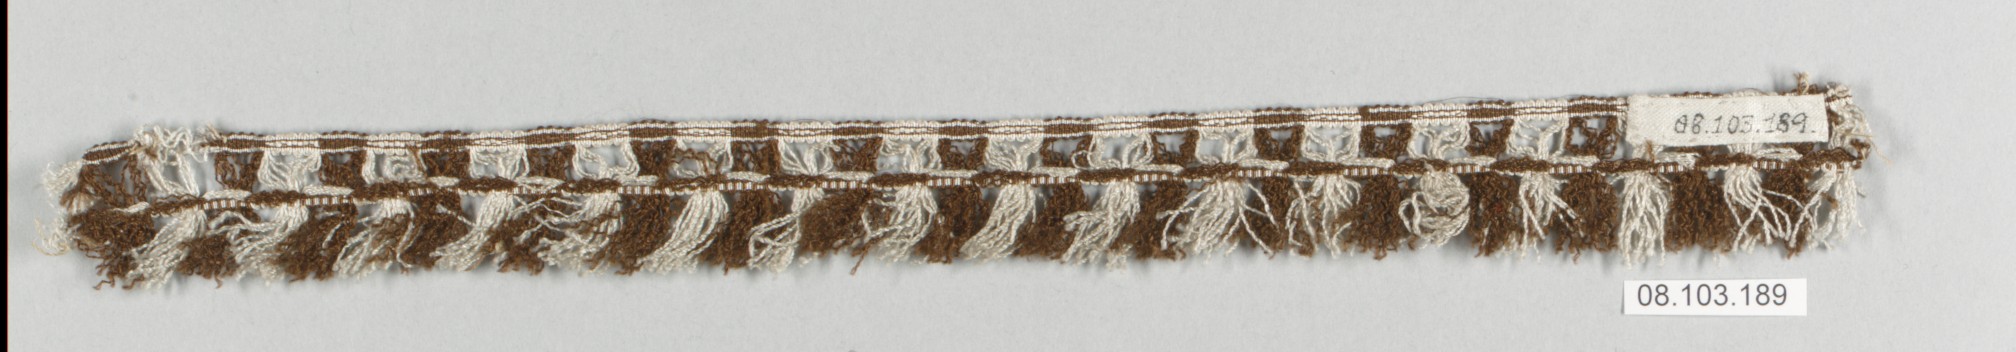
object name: fringe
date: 1801-1900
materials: silk